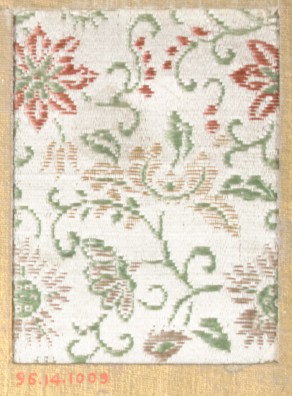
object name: piece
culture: japanese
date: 1701-1900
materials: silk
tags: flowers